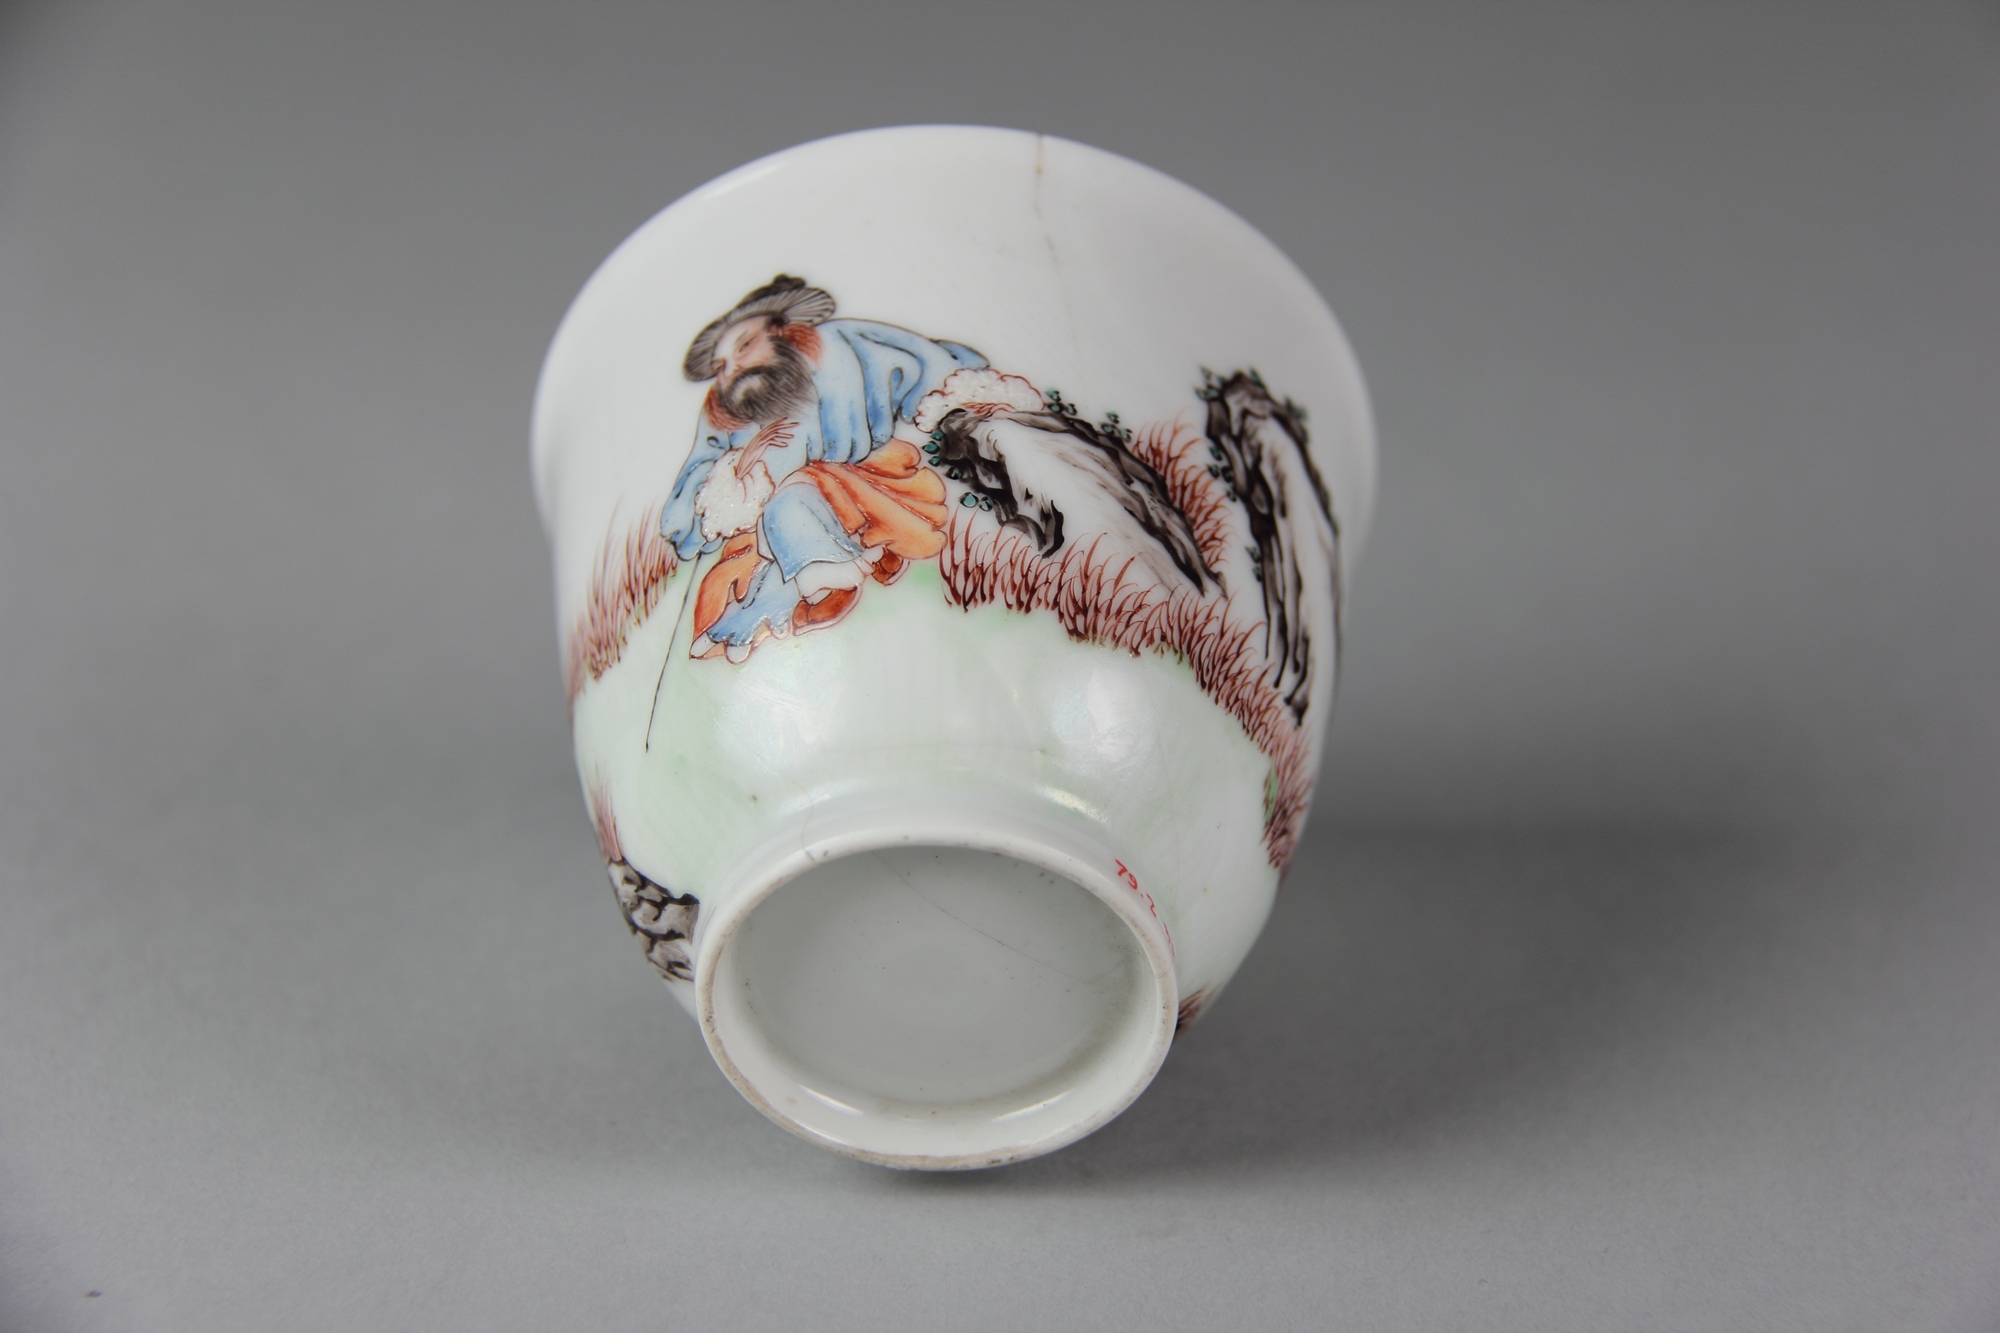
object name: cup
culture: chinese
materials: enamel, porcelain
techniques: overglaze, painting, polychrome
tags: men